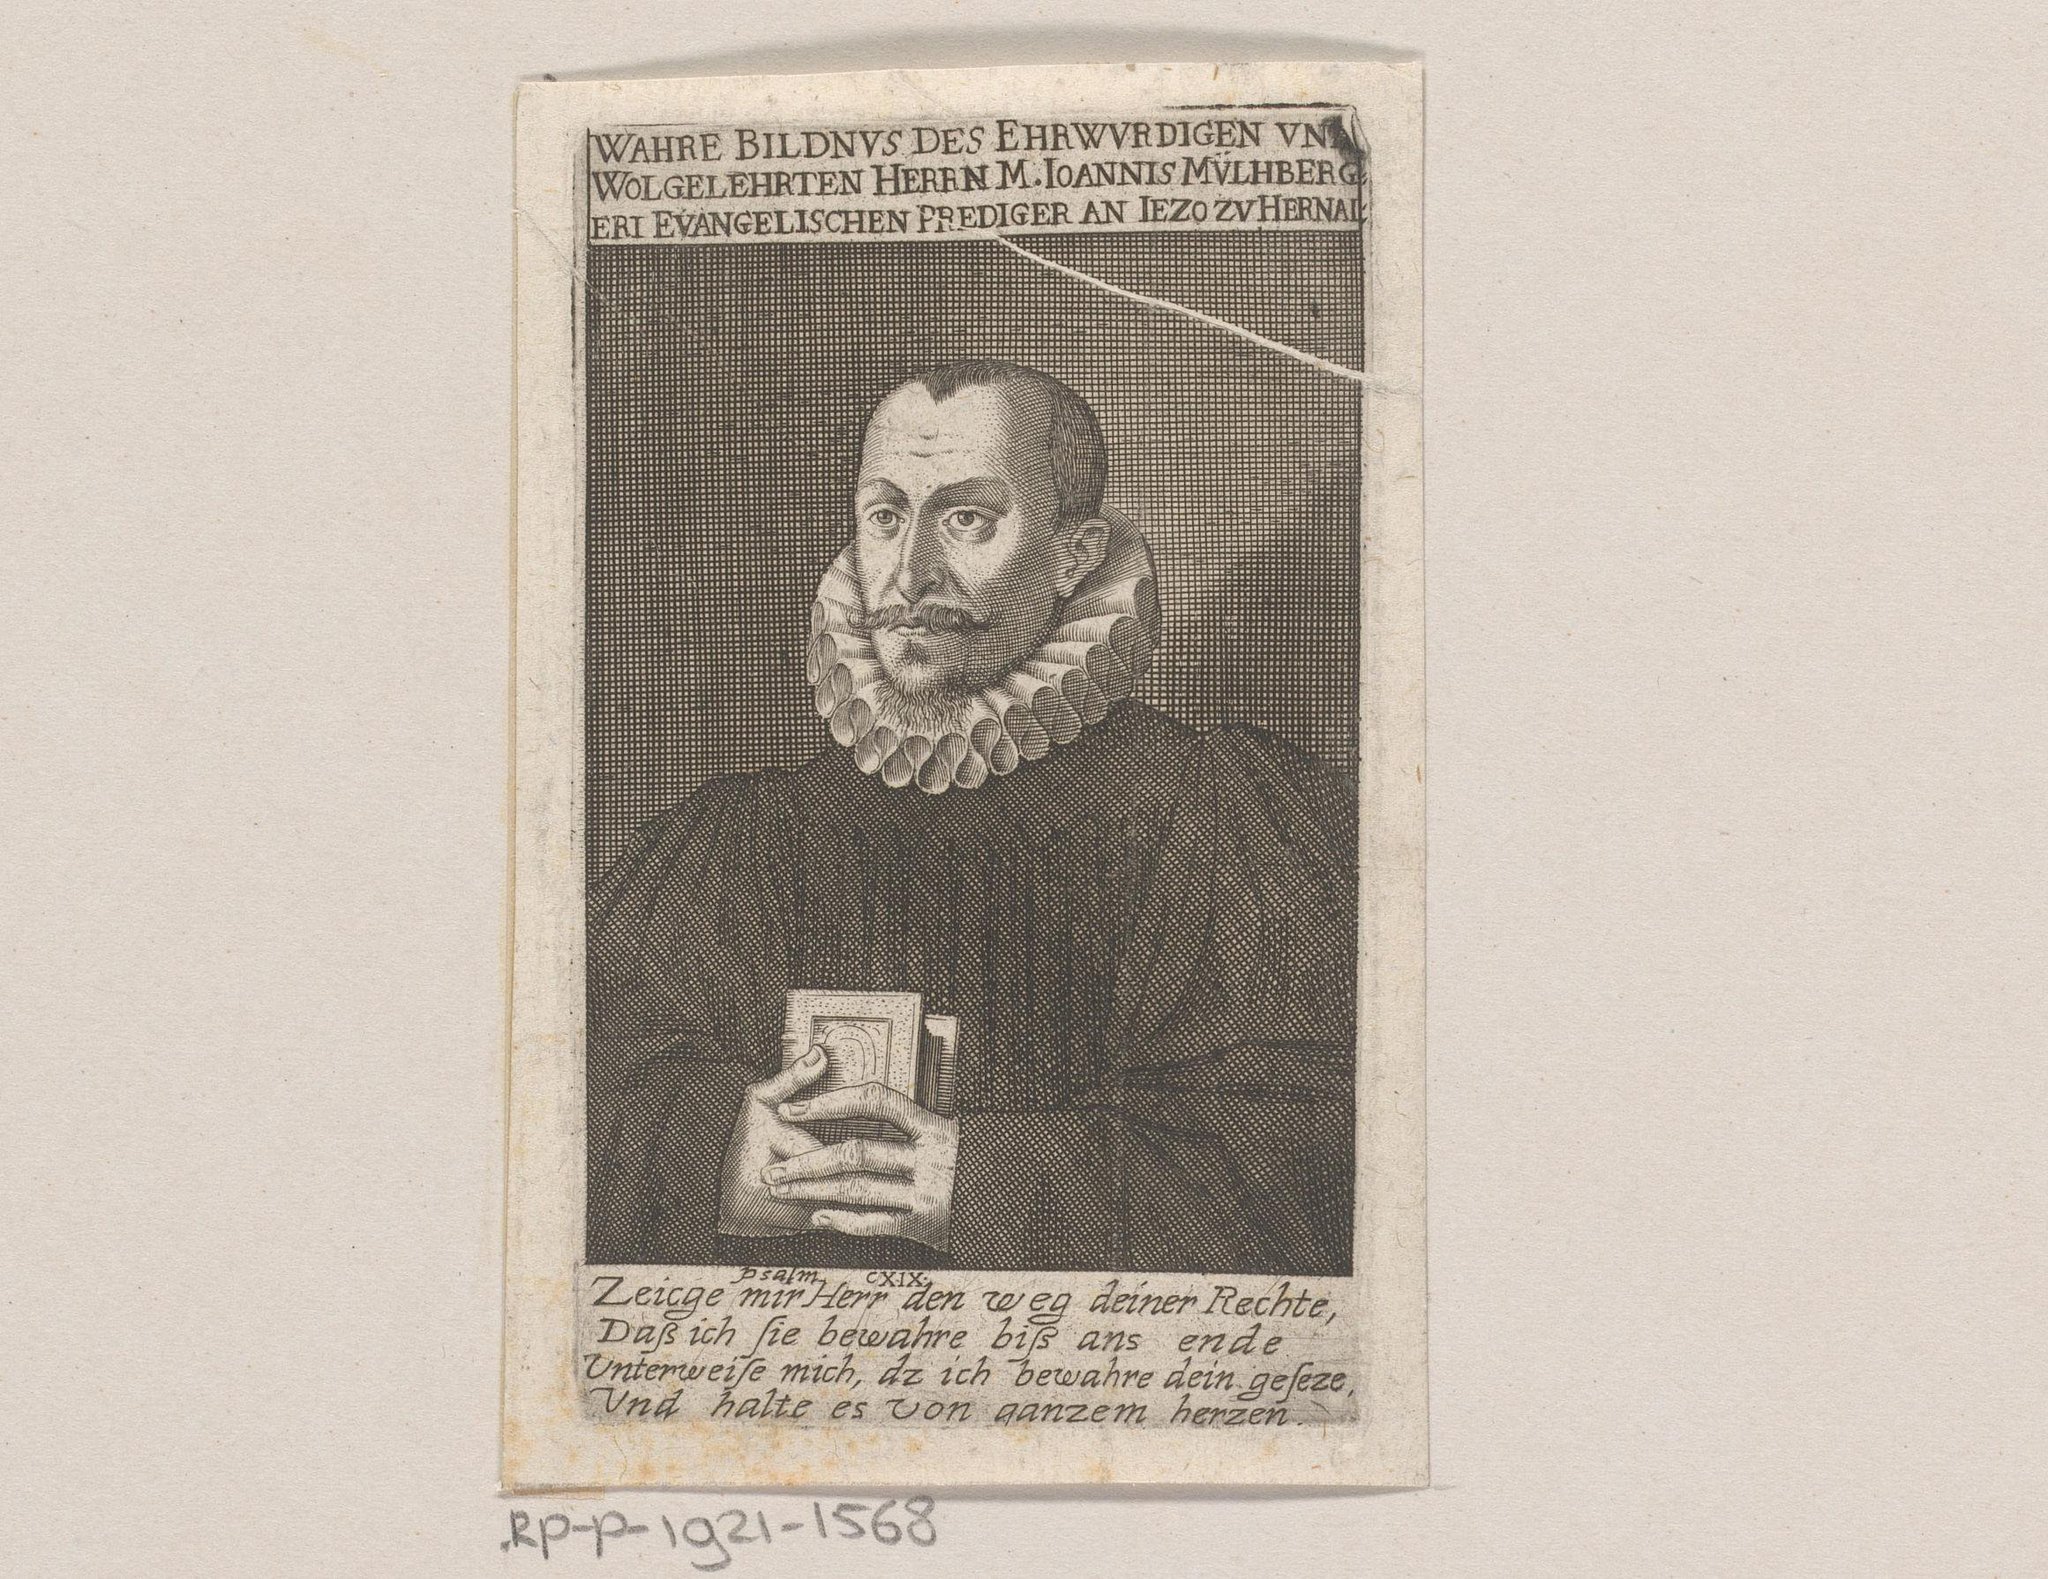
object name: print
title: M. Iohannis Mühlbergert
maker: Anonymous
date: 1600-1750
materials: paper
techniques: engraving, intaglio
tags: historical persons, organization, functionaries and dignitaries in churches and in related institutions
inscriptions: collector's mark: Lugt 2233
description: Met vierregelig onderschrift in het Duits.